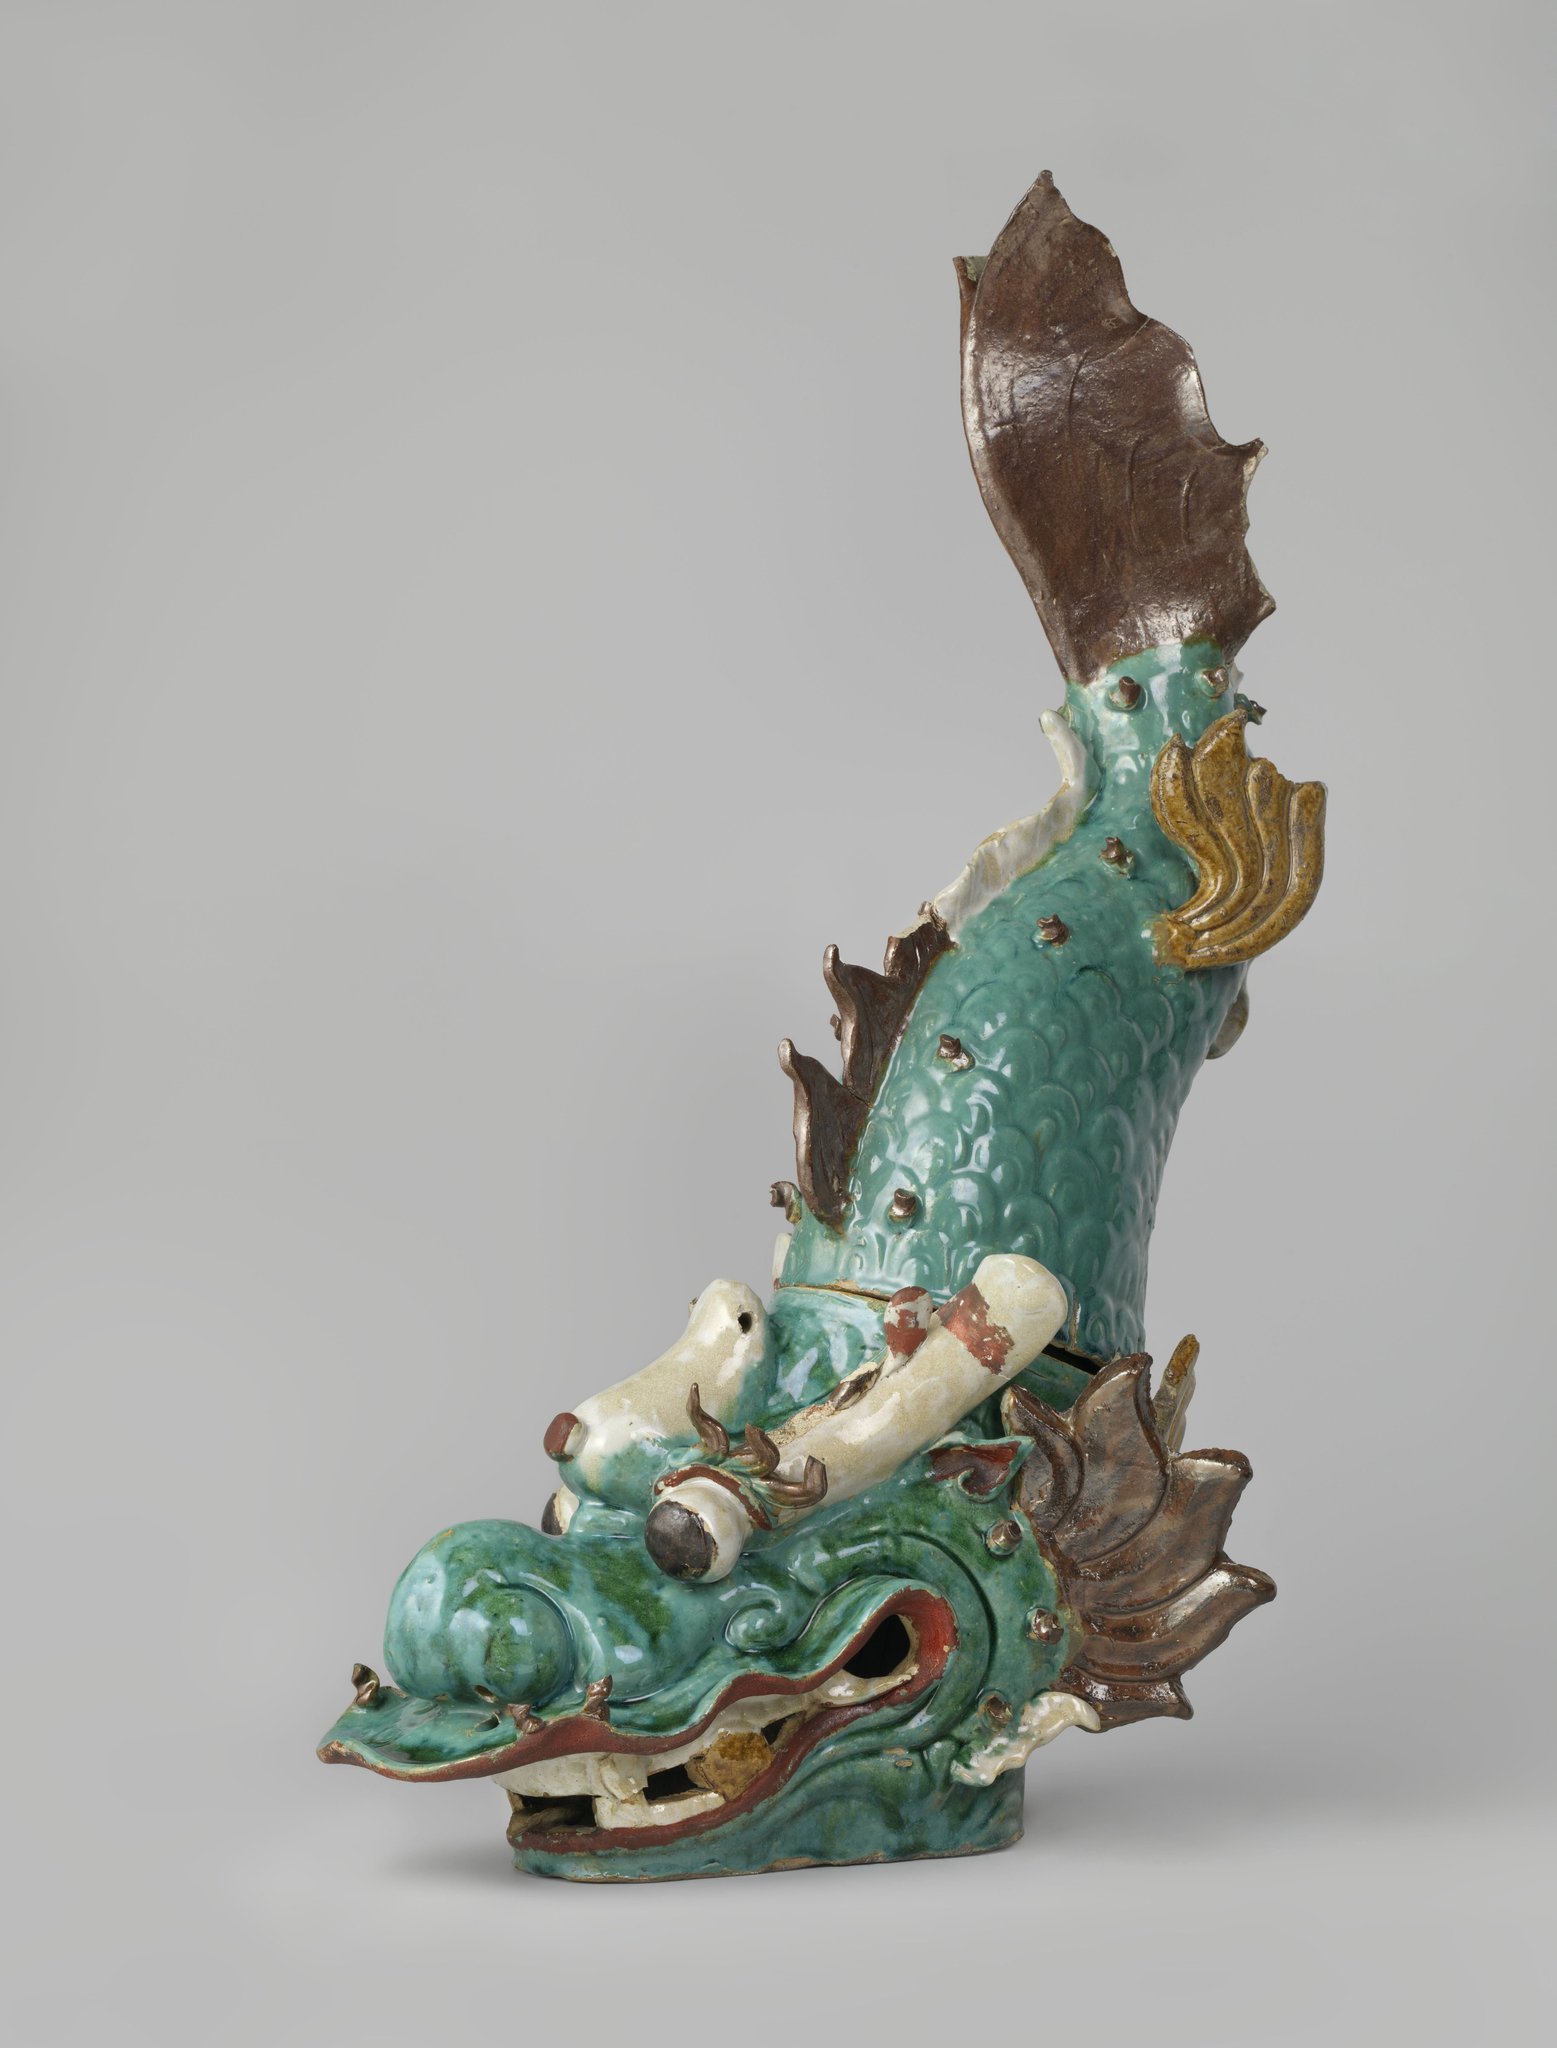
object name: sculpture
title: Draak/zeemonster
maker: Anonymous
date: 1850-1875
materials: dye, earthenware, glaze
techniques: vitrification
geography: china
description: Draak/zeemonster, bestaande uit twee delen, verbonden met een houten staaf. De draak staat op zijn onderkaak, de staart steekt omhoog. Blauw, bruin, rood en wit geglazuurd en beschilderd.